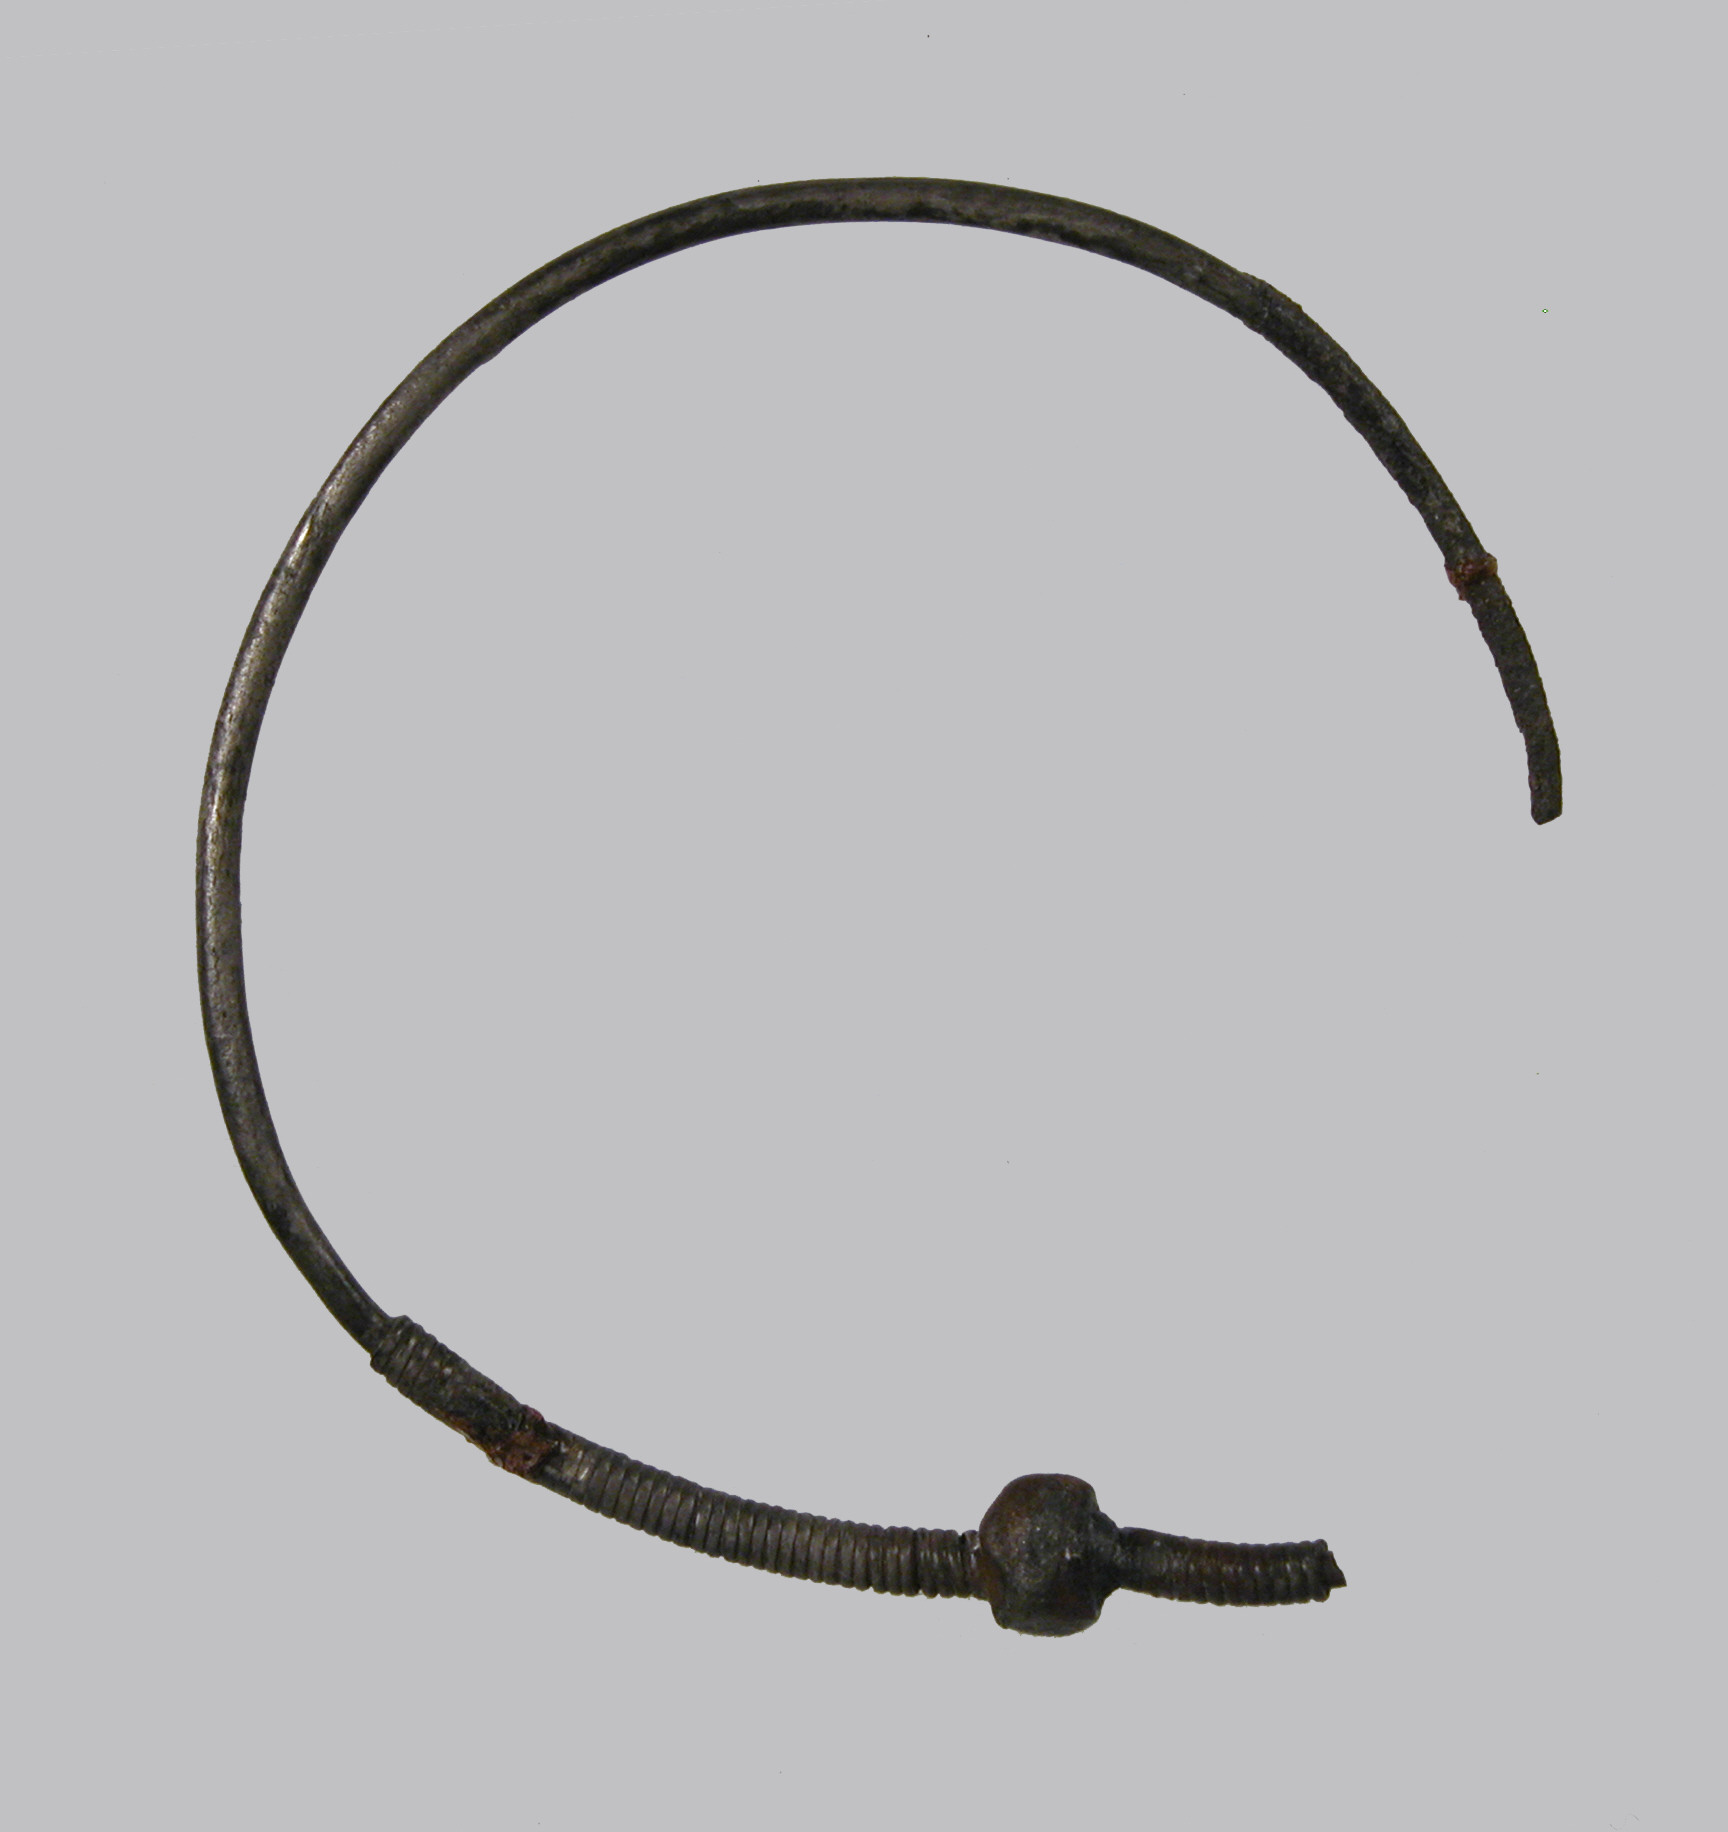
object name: earring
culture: frankish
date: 601-700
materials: silver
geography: germany